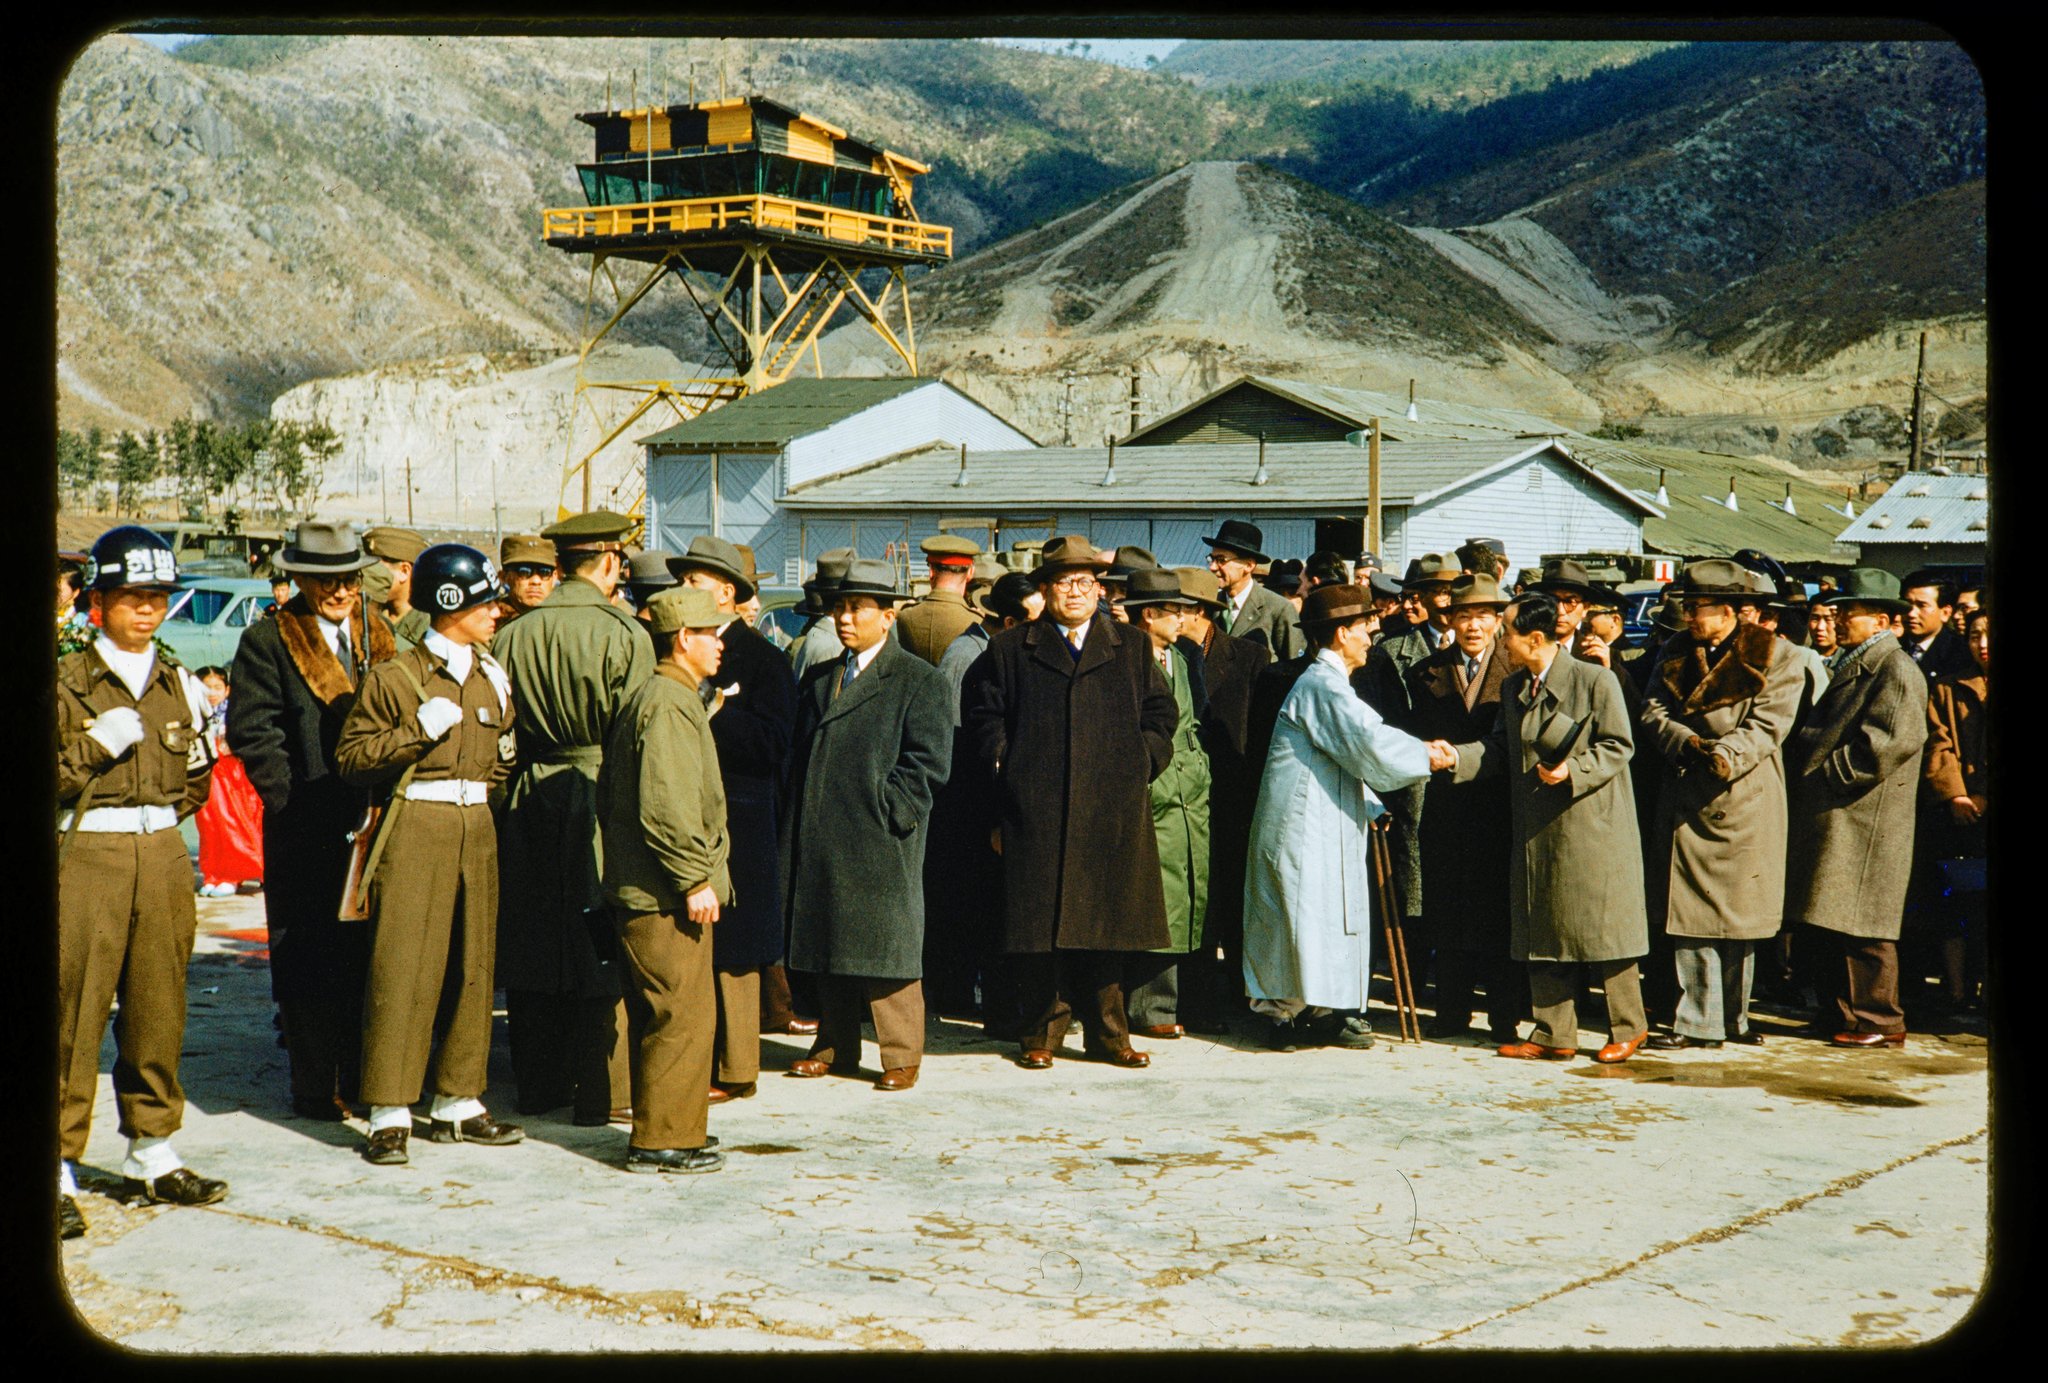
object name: color slide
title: Afscheid van de heer Van Fleet, Busan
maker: david ketel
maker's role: diplomaat, sinoloog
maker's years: 1913-2008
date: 1953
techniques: slide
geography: busan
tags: united nations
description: Afscheid van de heer Van Fleet op het vliegveld van Busan, winter 1953.